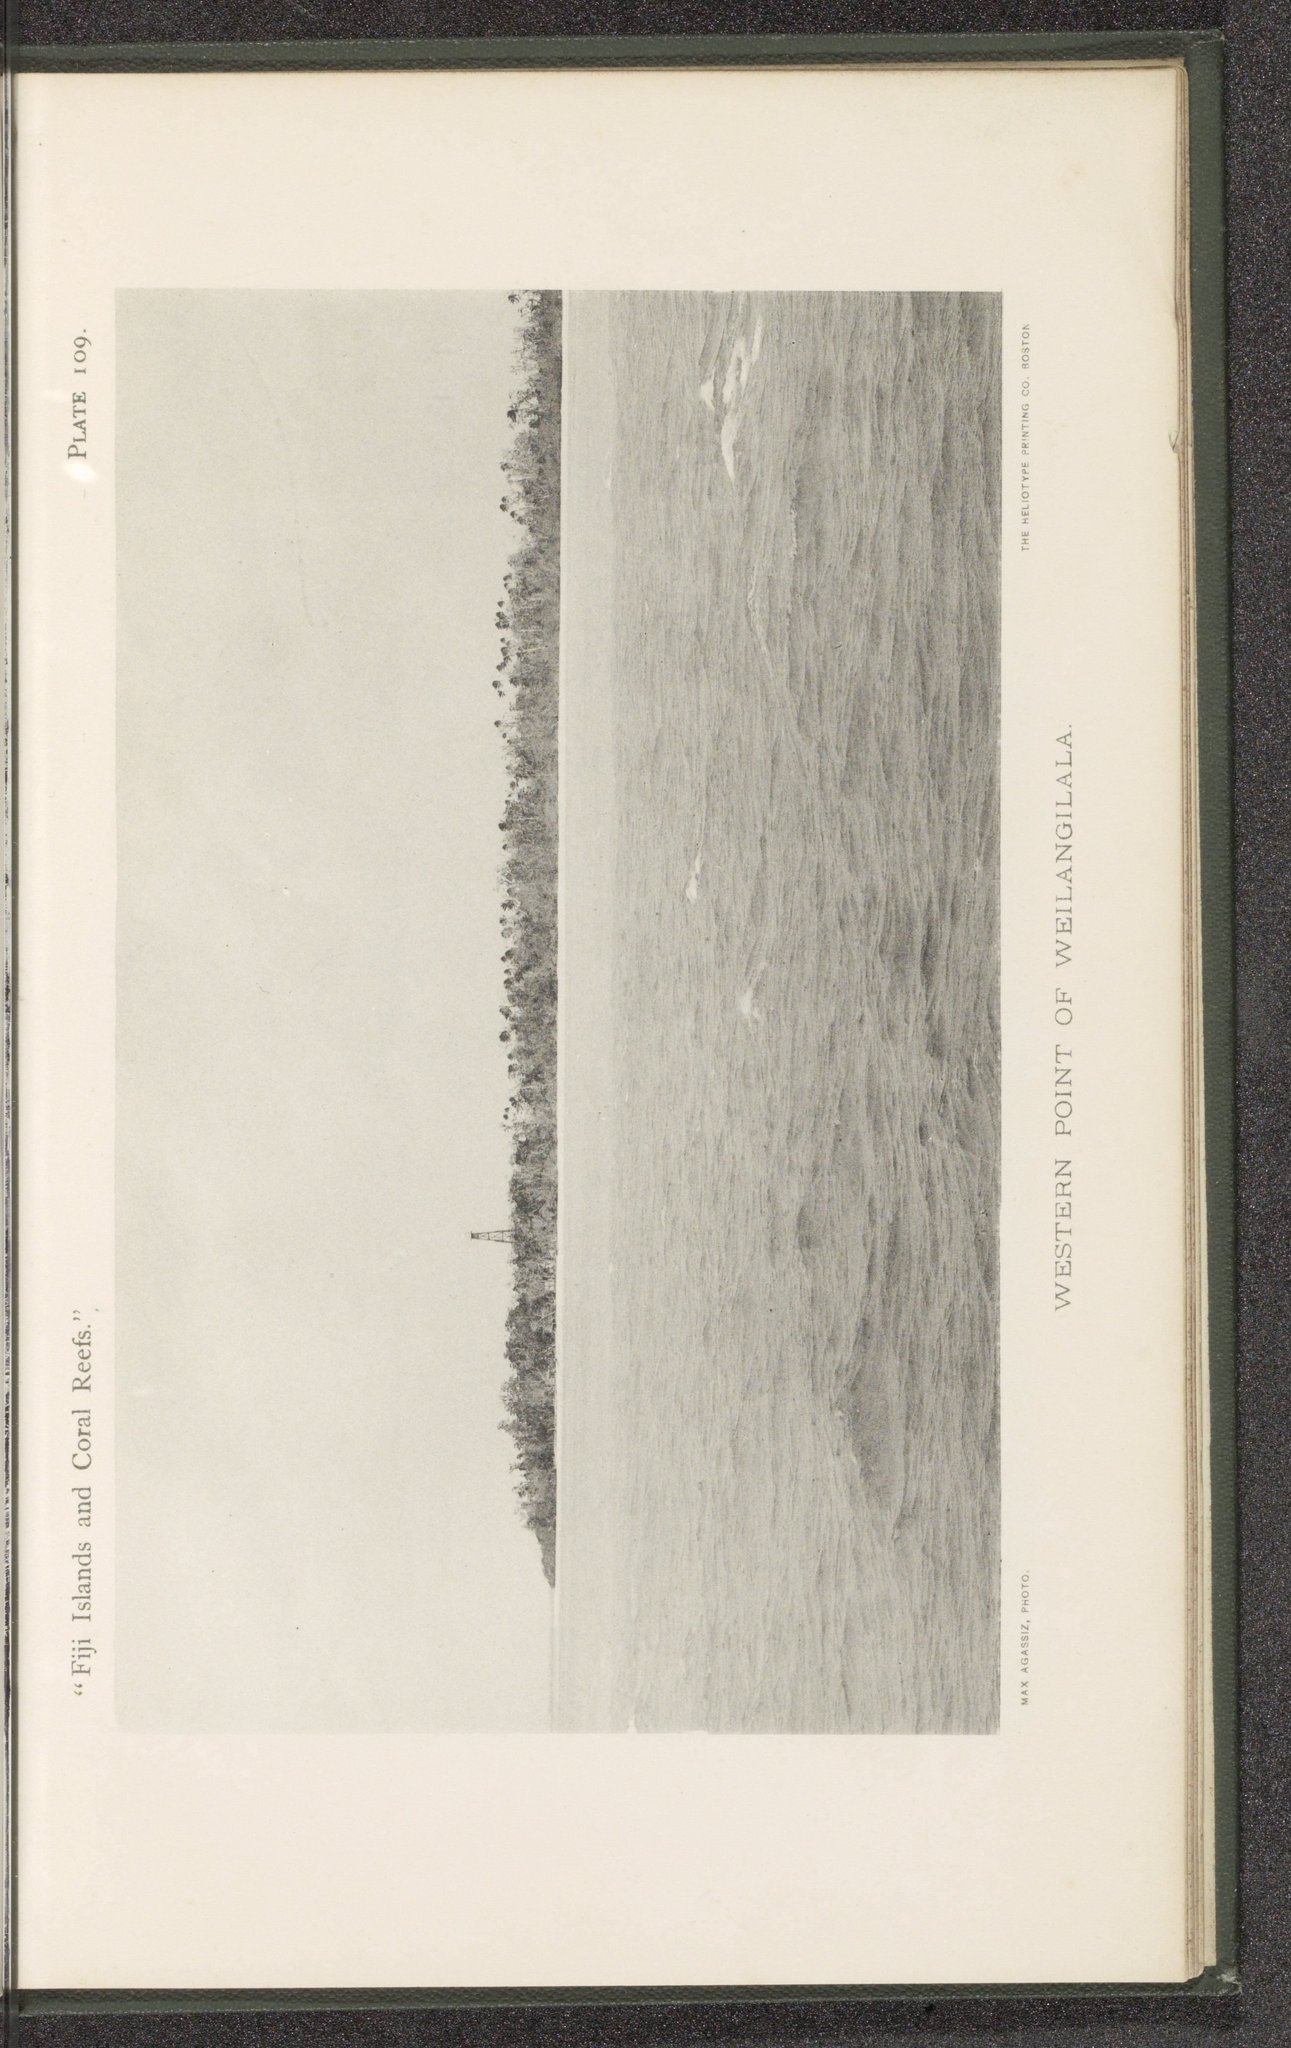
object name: page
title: Gezicht op Wailagi Lala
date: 1885-1899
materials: paper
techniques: photograph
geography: fiji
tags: island, ocean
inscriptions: number: ‘Plate 109.’, name: ‘The Heliotype Printing Co. Boston’, name: ‘Max Agassiz, Photo.’